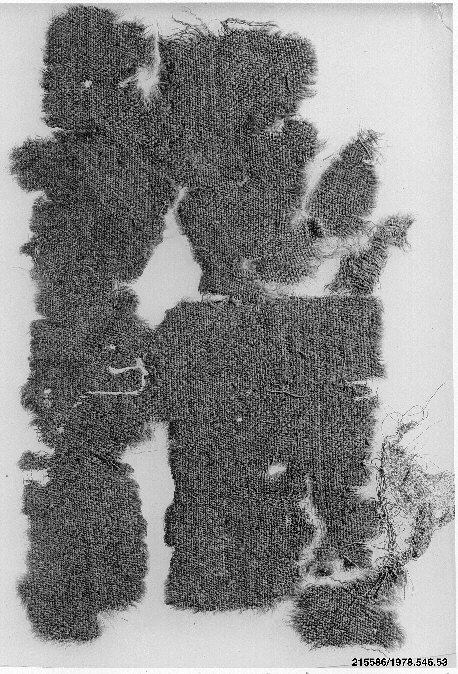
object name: textile fragment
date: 801-1000